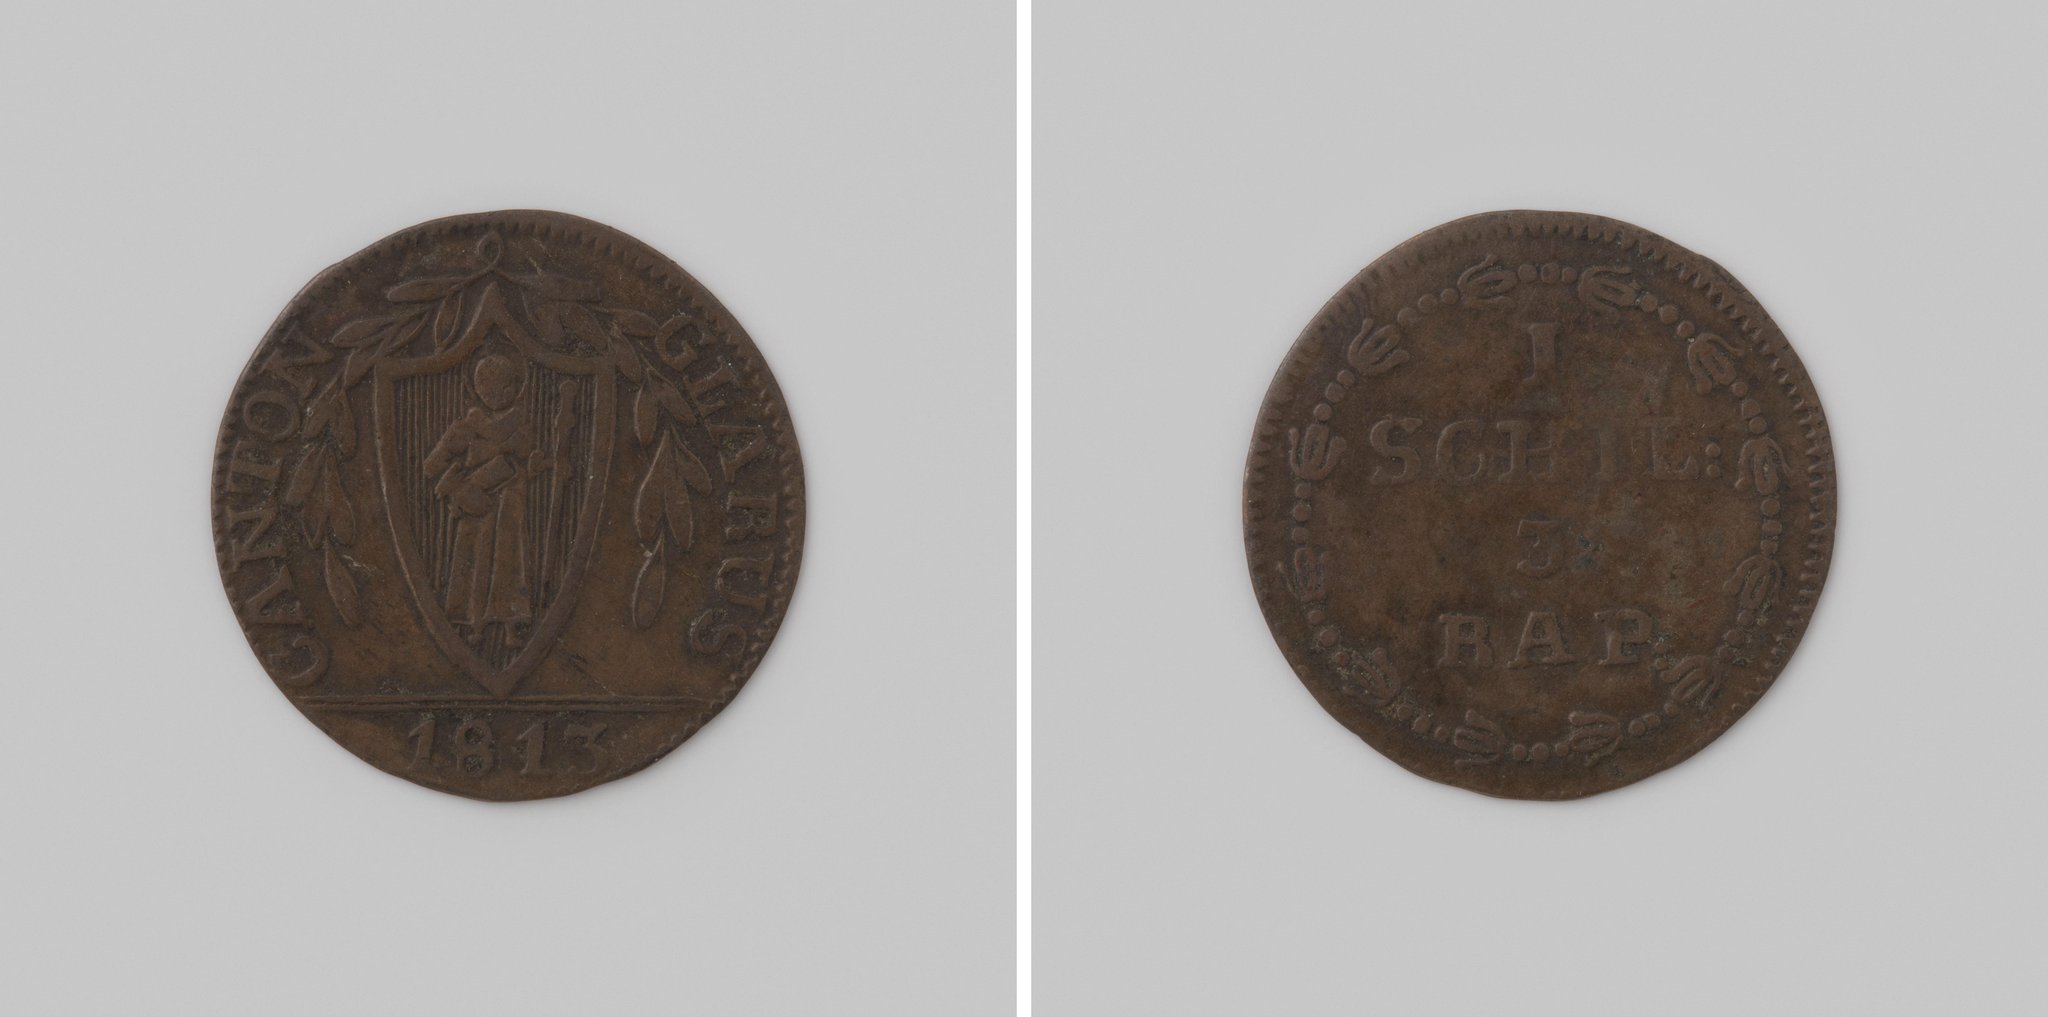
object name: coin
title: Kanton Glarus, schilling of 3 rappen, 1813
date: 1813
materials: copper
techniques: striking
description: Koperen munt. Voorzijde: onder twee takken wapenschild. In afsnede jaartal. Keerzijde: binnen krans van bladeren in drie regels waarde-aanduiding. Gladde rand.